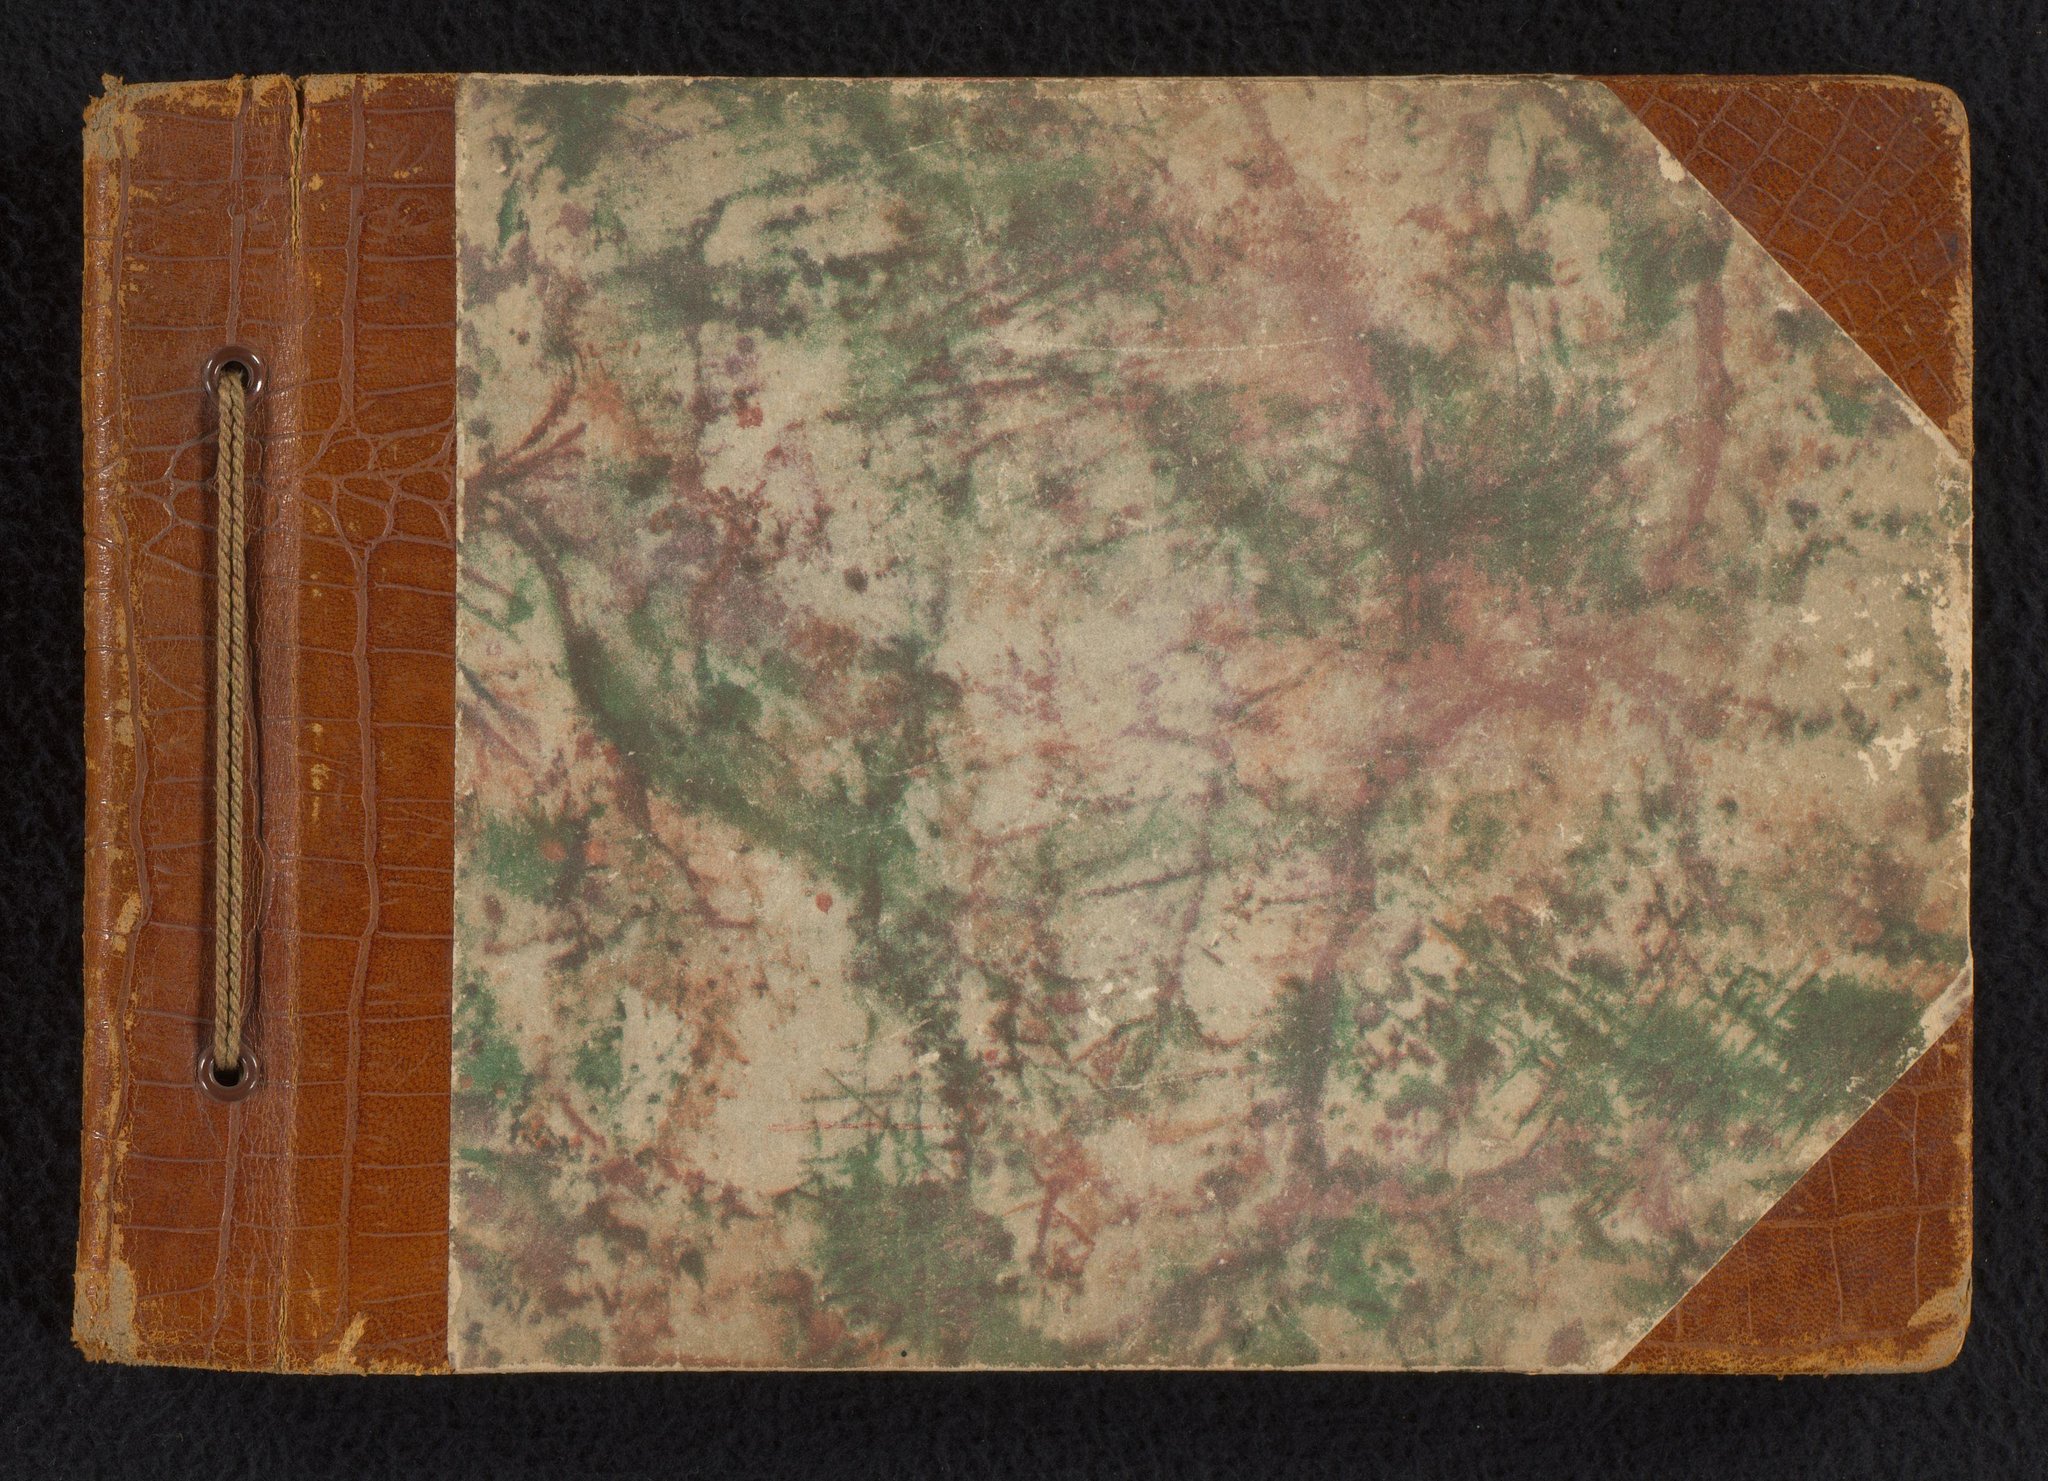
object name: scrapbook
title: Album met foto's van familie Furnée-Onnen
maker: Anonymous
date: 1920-1930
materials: paper, cardboard, leather, fiber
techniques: decorated paper, gelatin silver print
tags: the hague, the family travelling, on holiday, family life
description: Plakboek met 40 pagina's met 134 foto's. De laatste foto is op de binnenzijde van het achterplat geplakt. De afgebeelde personen zijn waarschijnlijk leden van het gezin van Carolina Furnée Onnen en Frank Willem Tobias Furnée. Het album bevat foto's van Frank, Pieter en Carola Furnée als baby, peuter en kind. Ook bevat het album foto's van familievakanties naar Noordwijk en de Côte d'Azur. De fotograaf en samensteller is onbekend, maar waarschijnlijk iemand uit de familie.